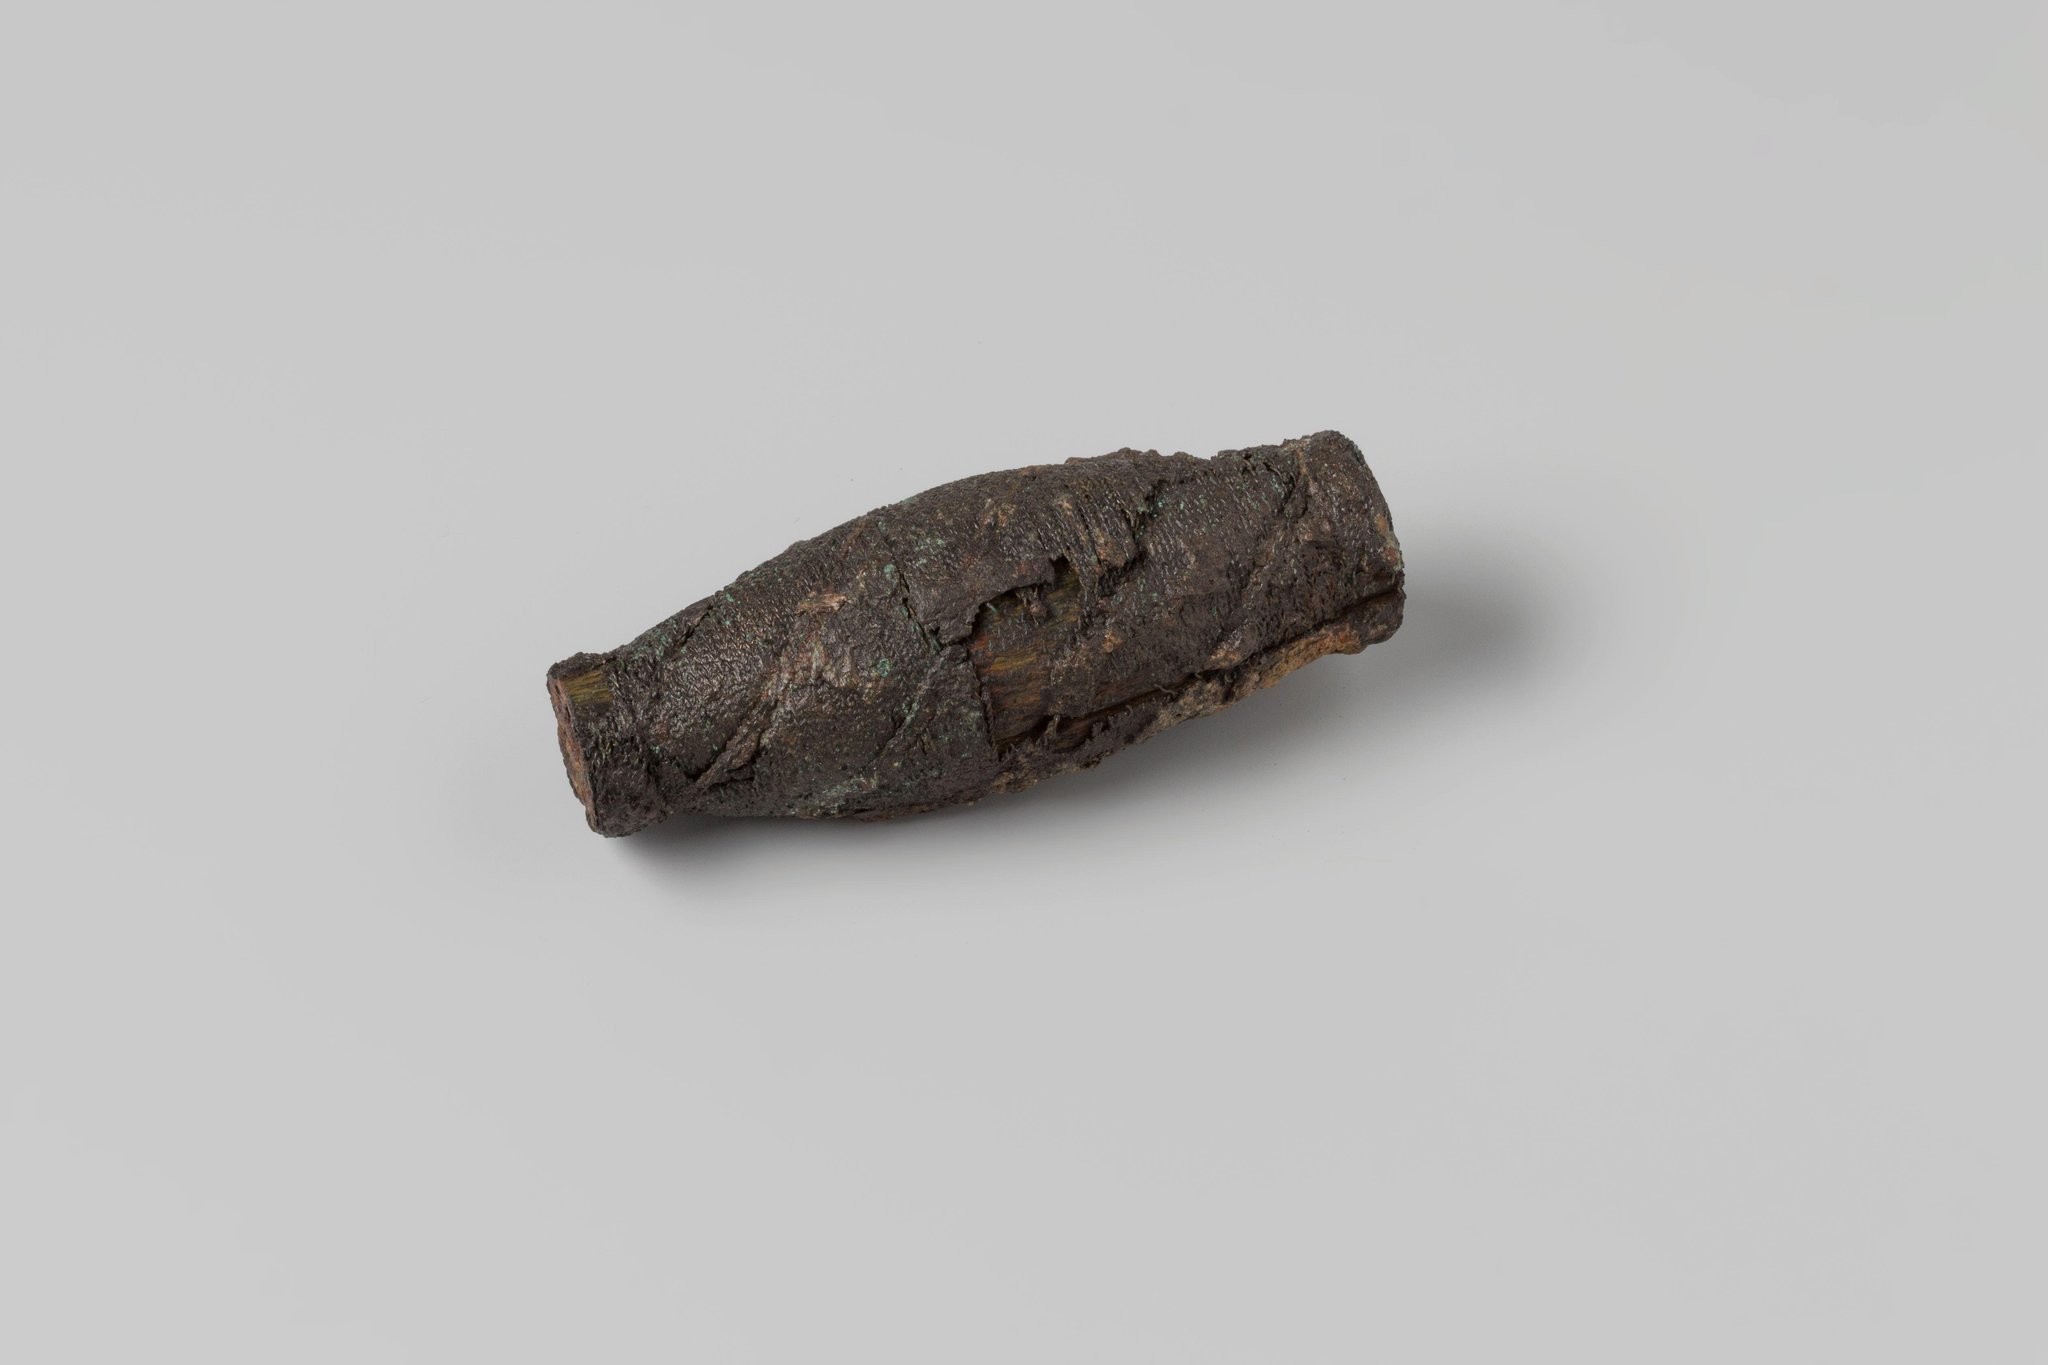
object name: greep gevest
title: Greep van een gevest uit het wrak van de Oost-Indiëvaarder Hollandia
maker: Anonymous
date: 1700-1743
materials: copper, wood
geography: netherlands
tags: verenigde oostindische compagnie, hollandia (schip), annet